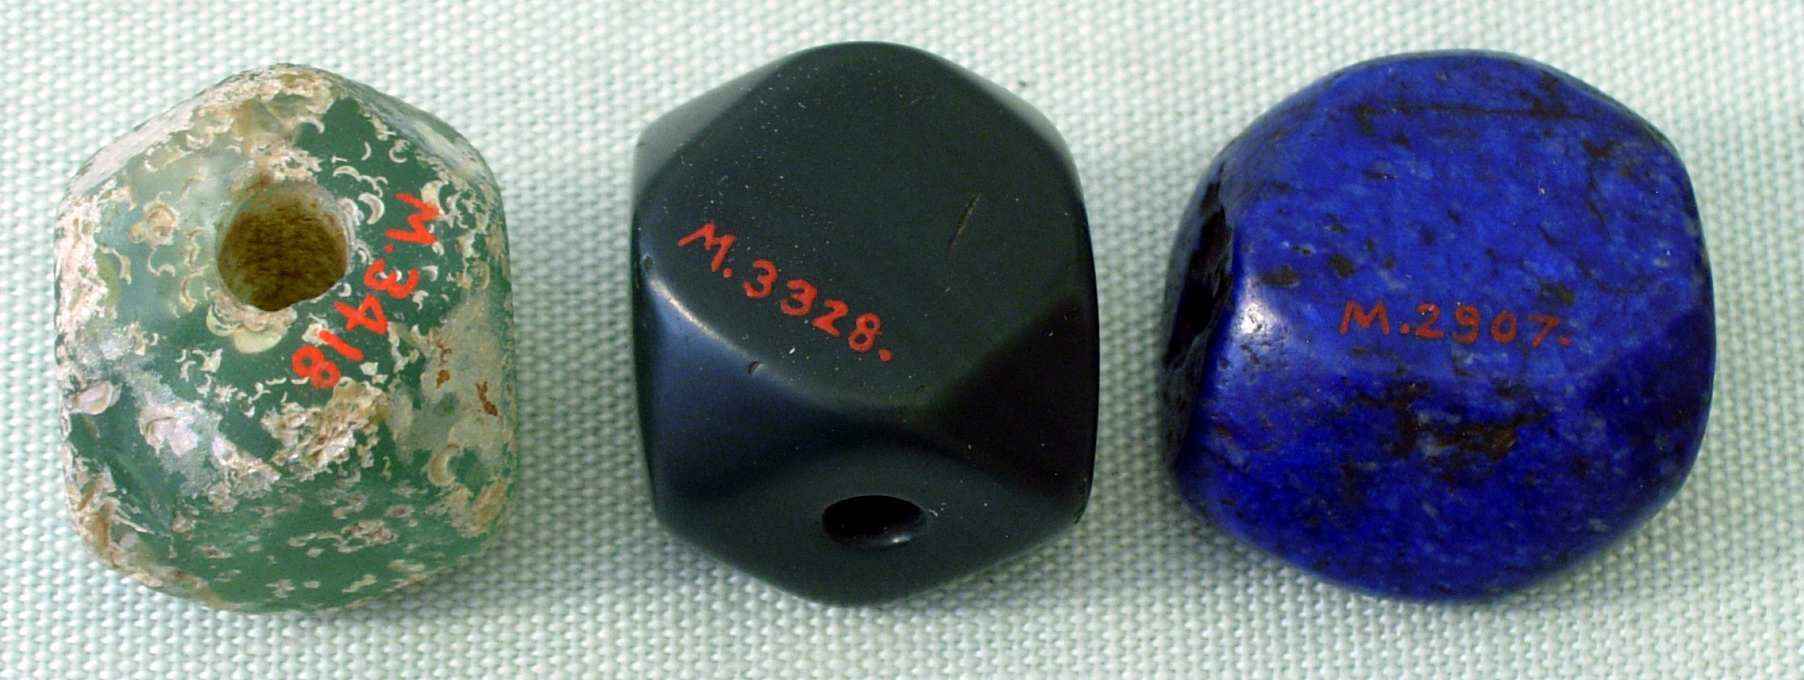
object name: bead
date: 801-1900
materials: glass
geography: egypt